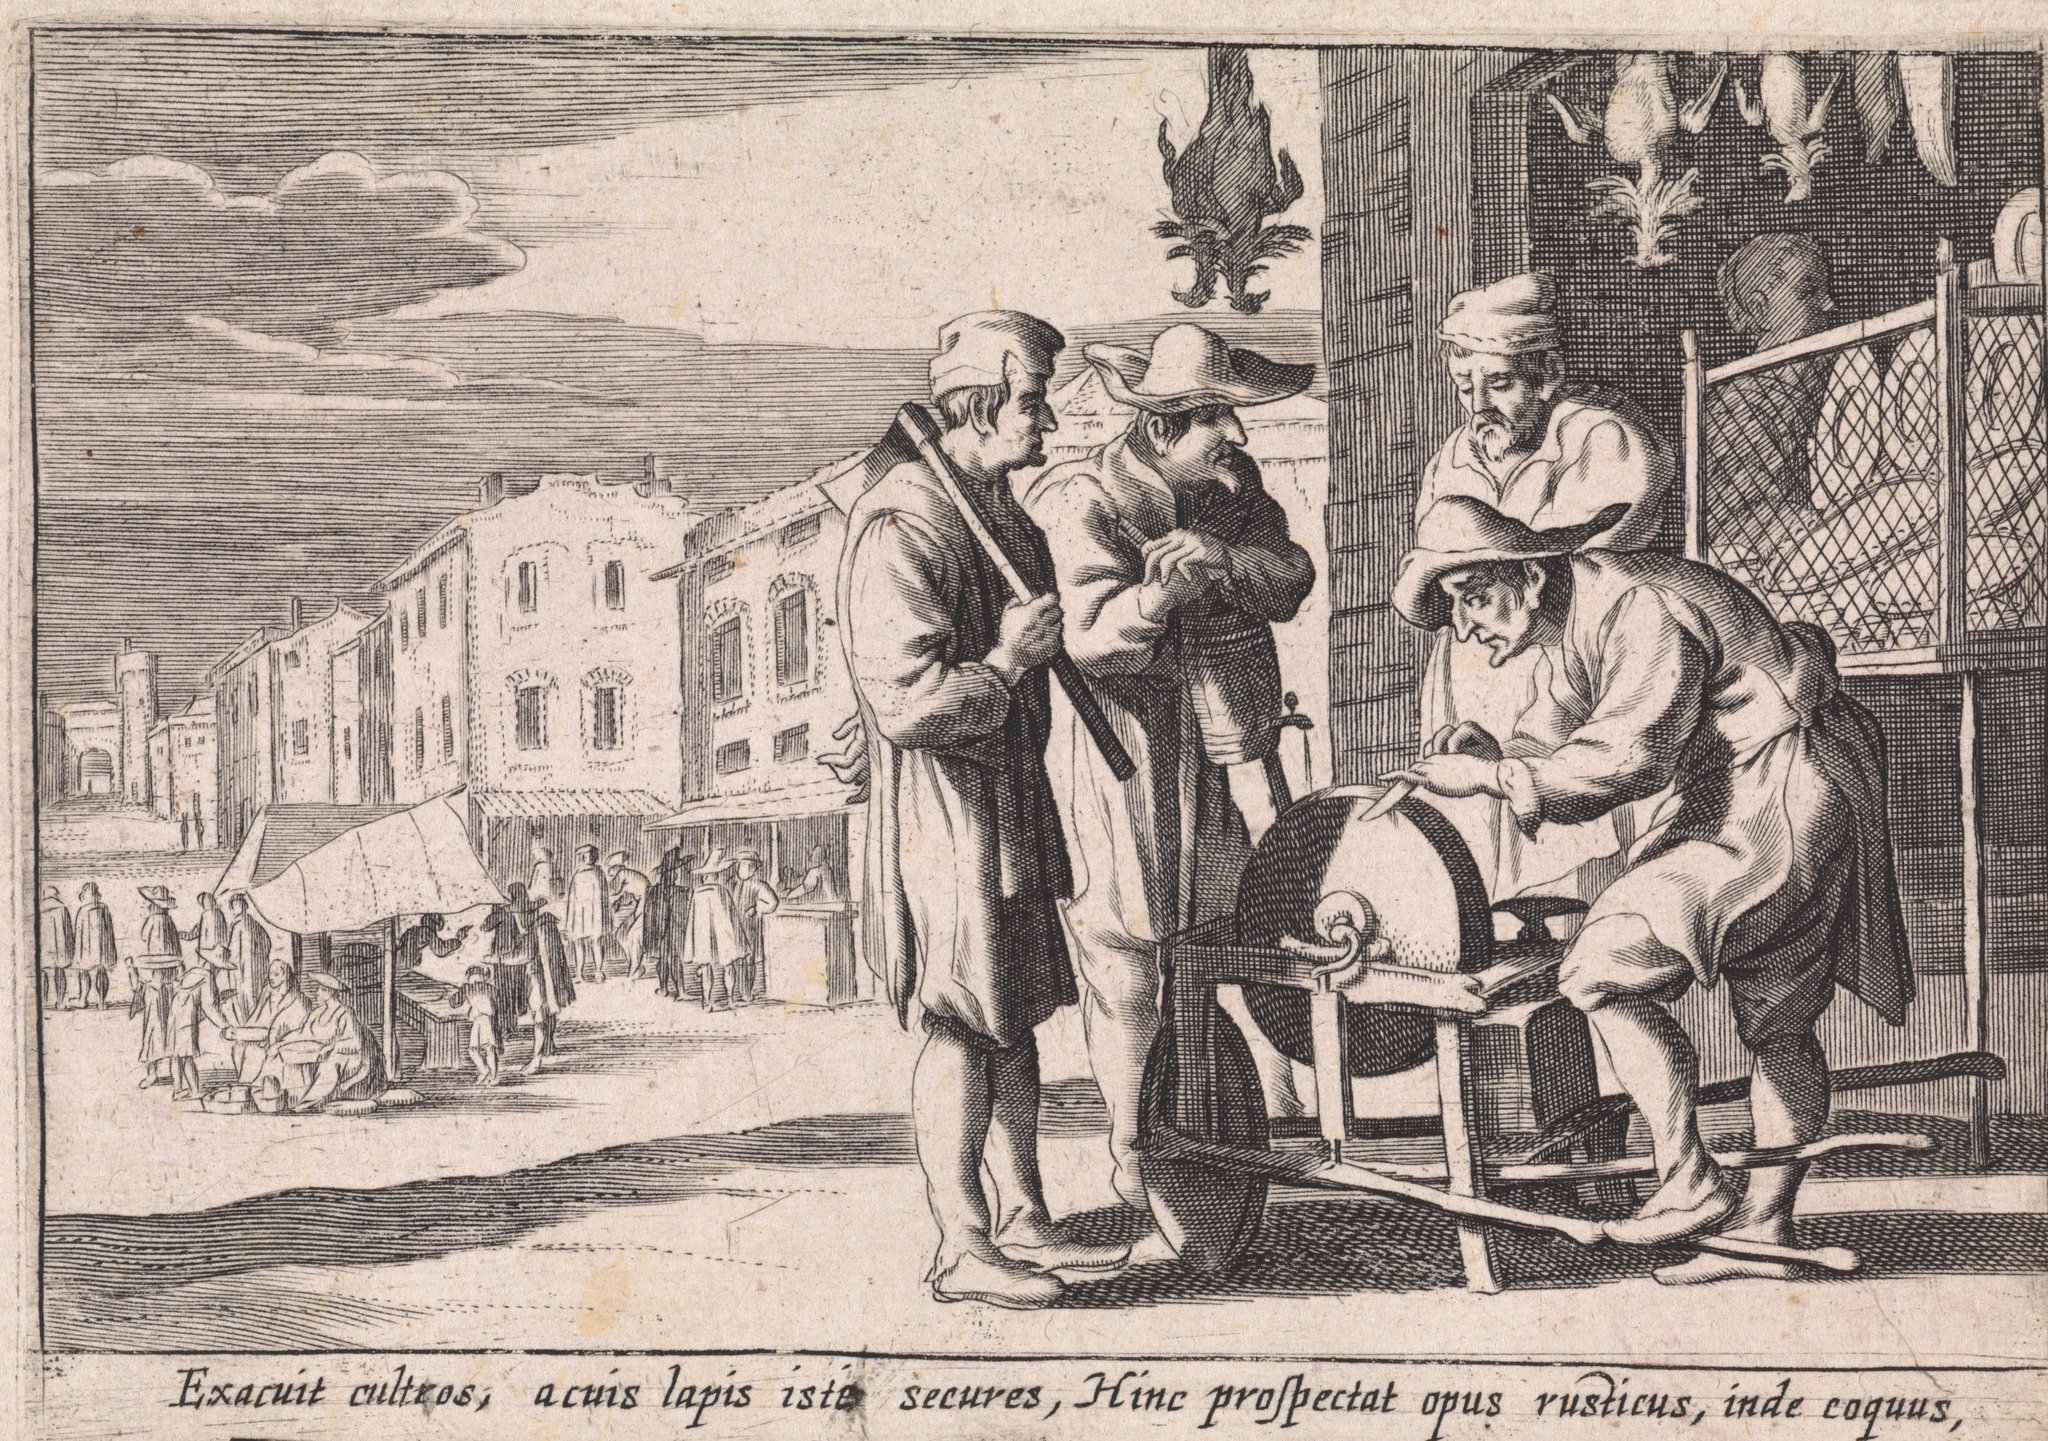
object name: print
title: Italiaanse handwerkslieden en verkopers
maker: Anonymous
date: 1613-1667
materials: paper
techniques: engraving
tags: handicrafts ~ maintenance and repair, tools, aids, implements ~ crafts and industries: knife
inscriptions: collector's mark: Lugt 240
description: Drie mannen kijken toe hoe een messenslijper zijn werk doet. Hij slijpt een mes op zijn kar waarop een natte zandsteen, die hij met zijn voet ronddraait. In de marge een onderschrift in het Latijn.